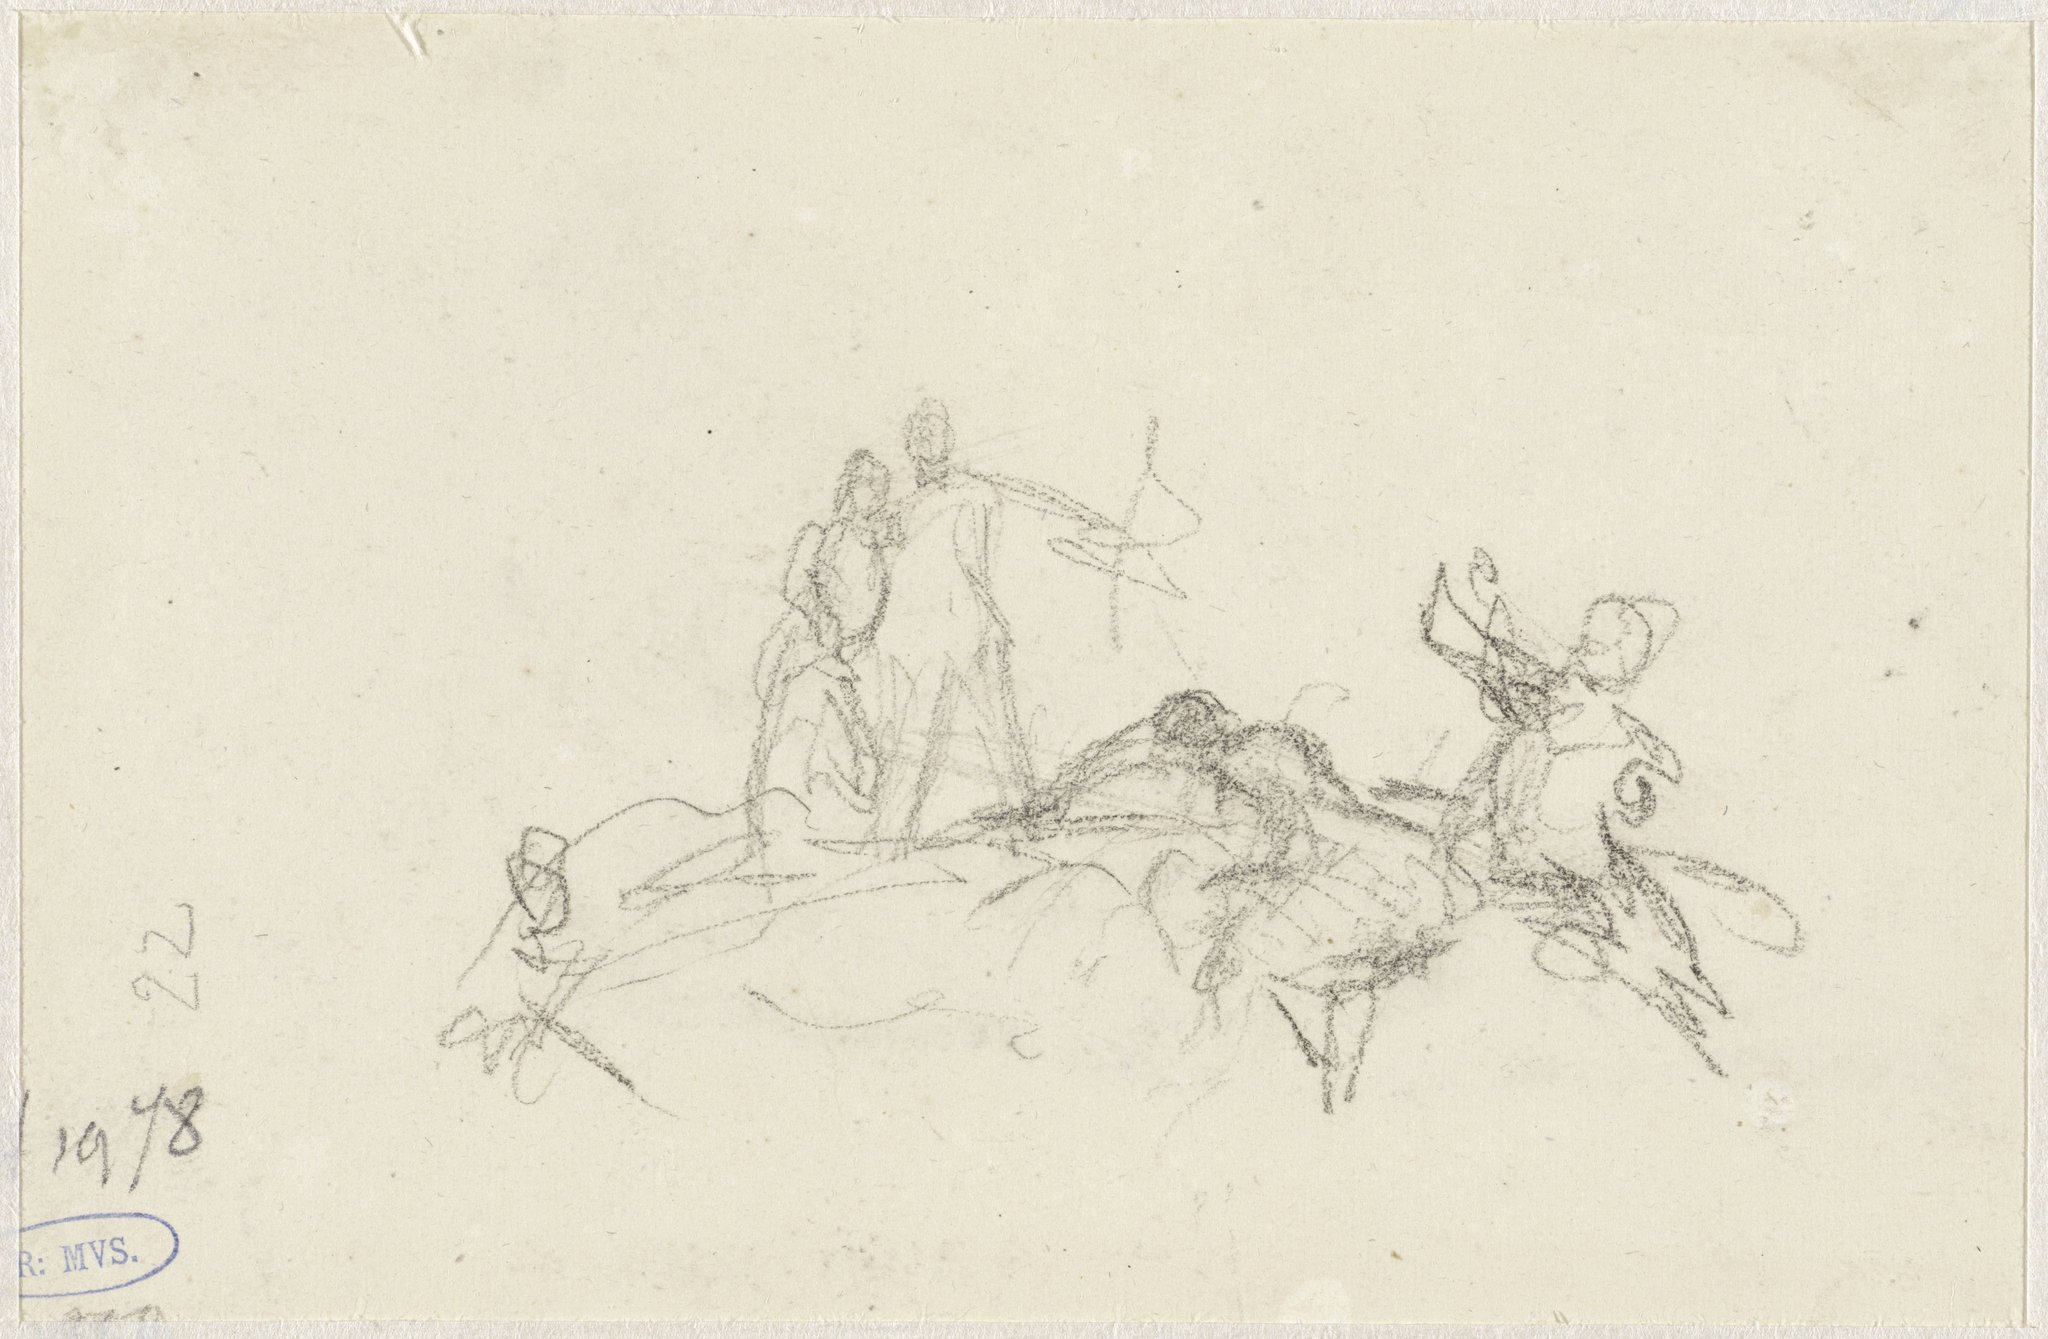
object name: drawing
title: Schets van enkele figuren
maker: johan daniël koelman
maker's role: draughtsman, print maker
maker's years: 1831-1857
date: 1841-1857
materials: chalk, paper